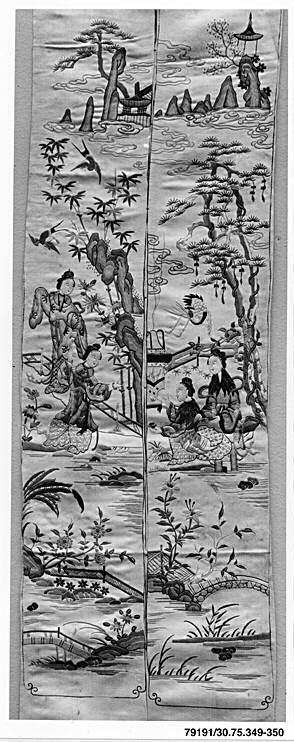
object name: sleeve band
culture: chinese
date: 1801-1900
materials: metal thread, silk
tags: girls,women